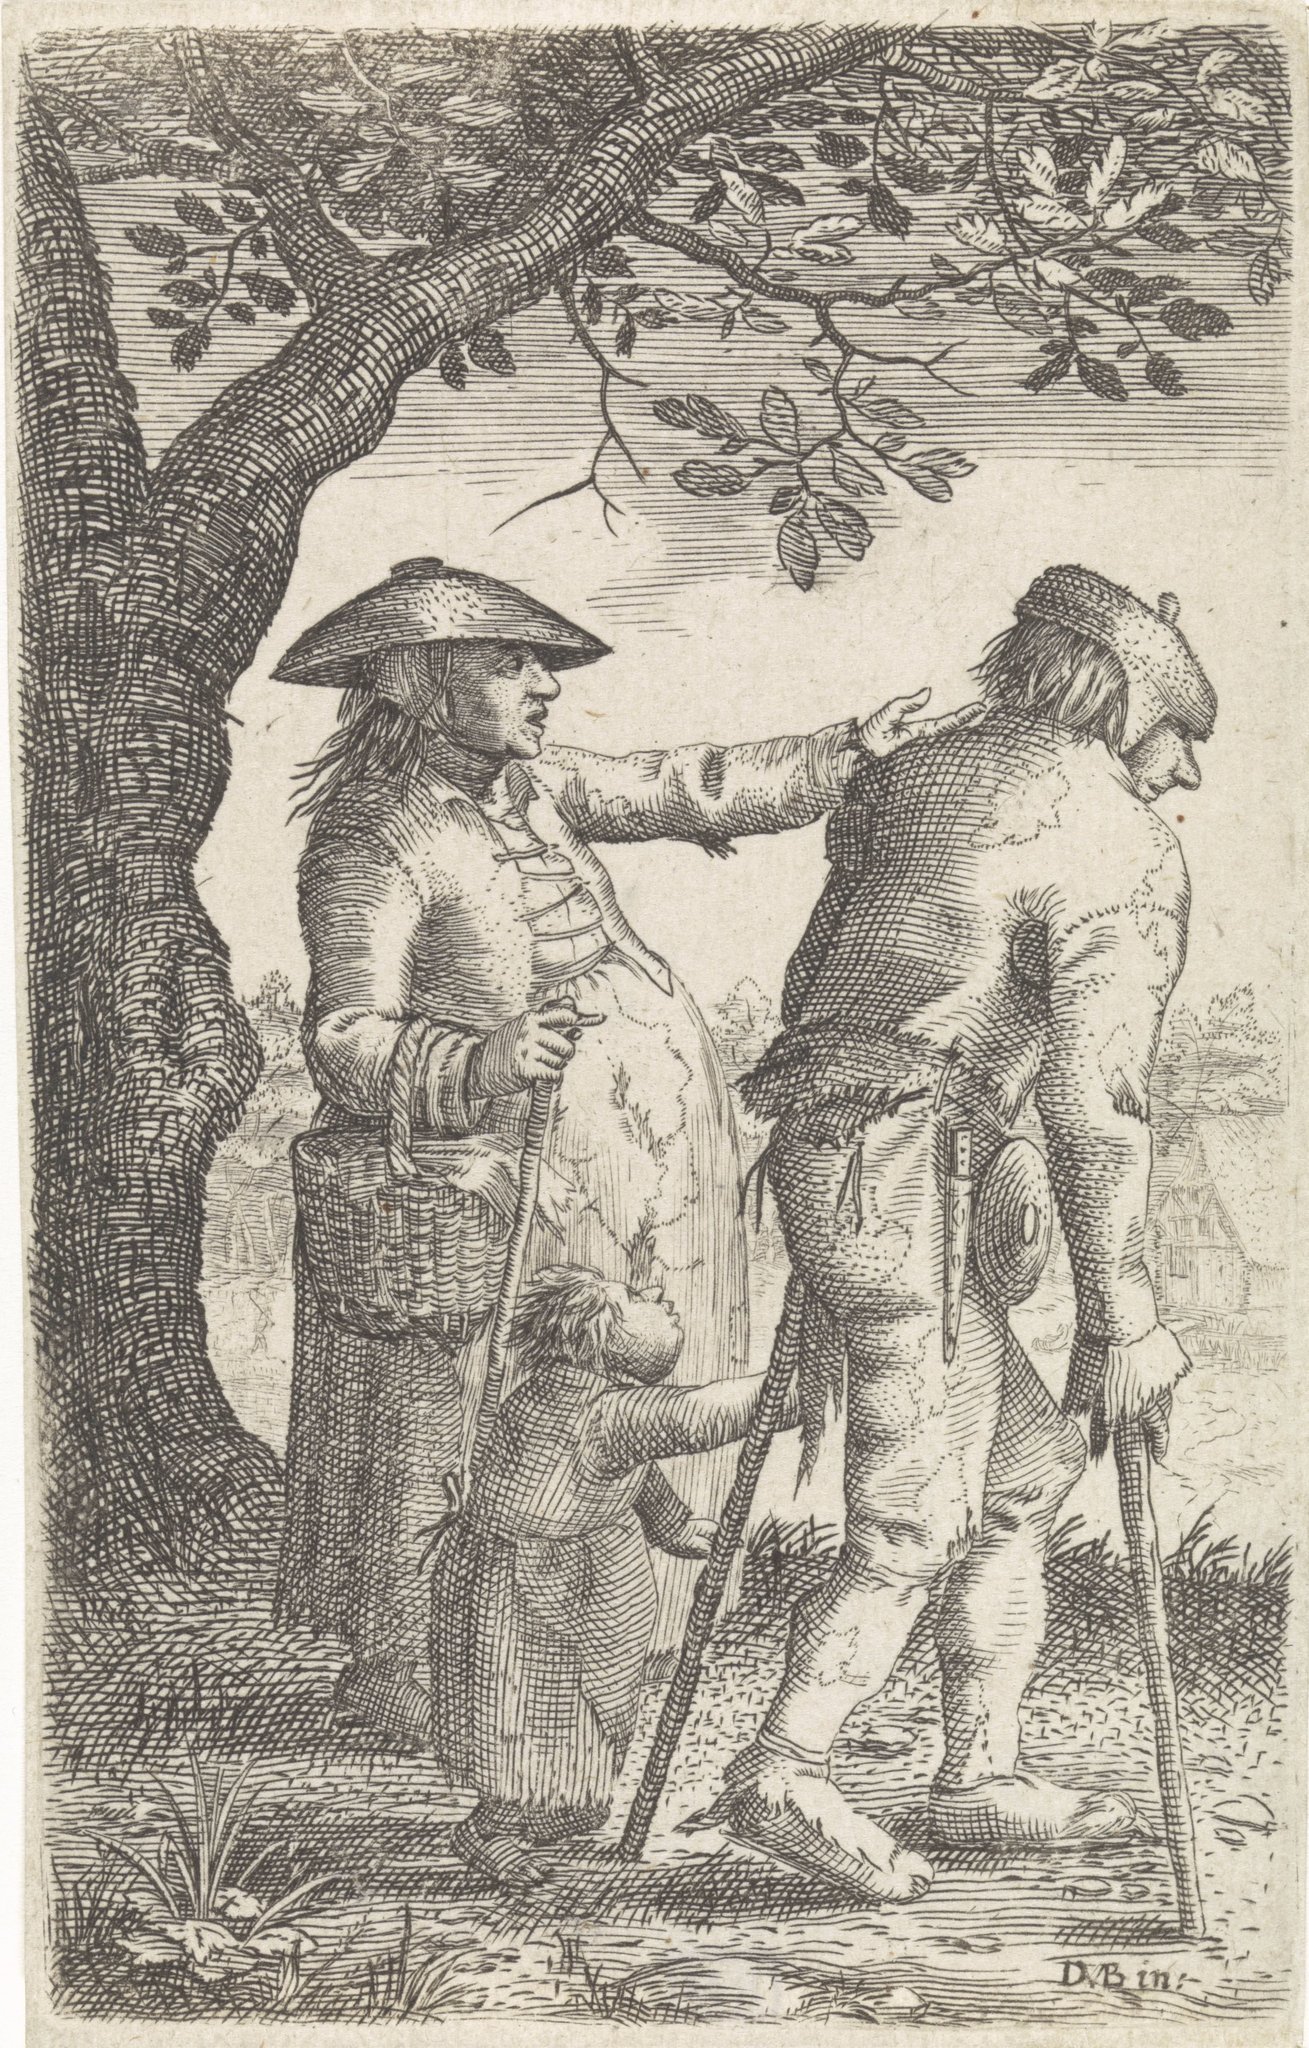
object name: print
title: Bedelaars op krukken bij een vrouw en een kind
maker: Anonymous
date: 1608-1612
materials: paper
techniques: engraving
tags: crutches, carrying something in basket, bag, rucksack, etc., mother and baby or young child, beggar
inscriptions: collector's mark: Lugt 2227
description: Een man op krukken bij een vrouw die de linkerhand uitstrekt. De vrouw heeft een mand aan de rechterarm en een stok in de rechterhand. Tussen hen in staat een kind dat de rechterarm uitsterkt.